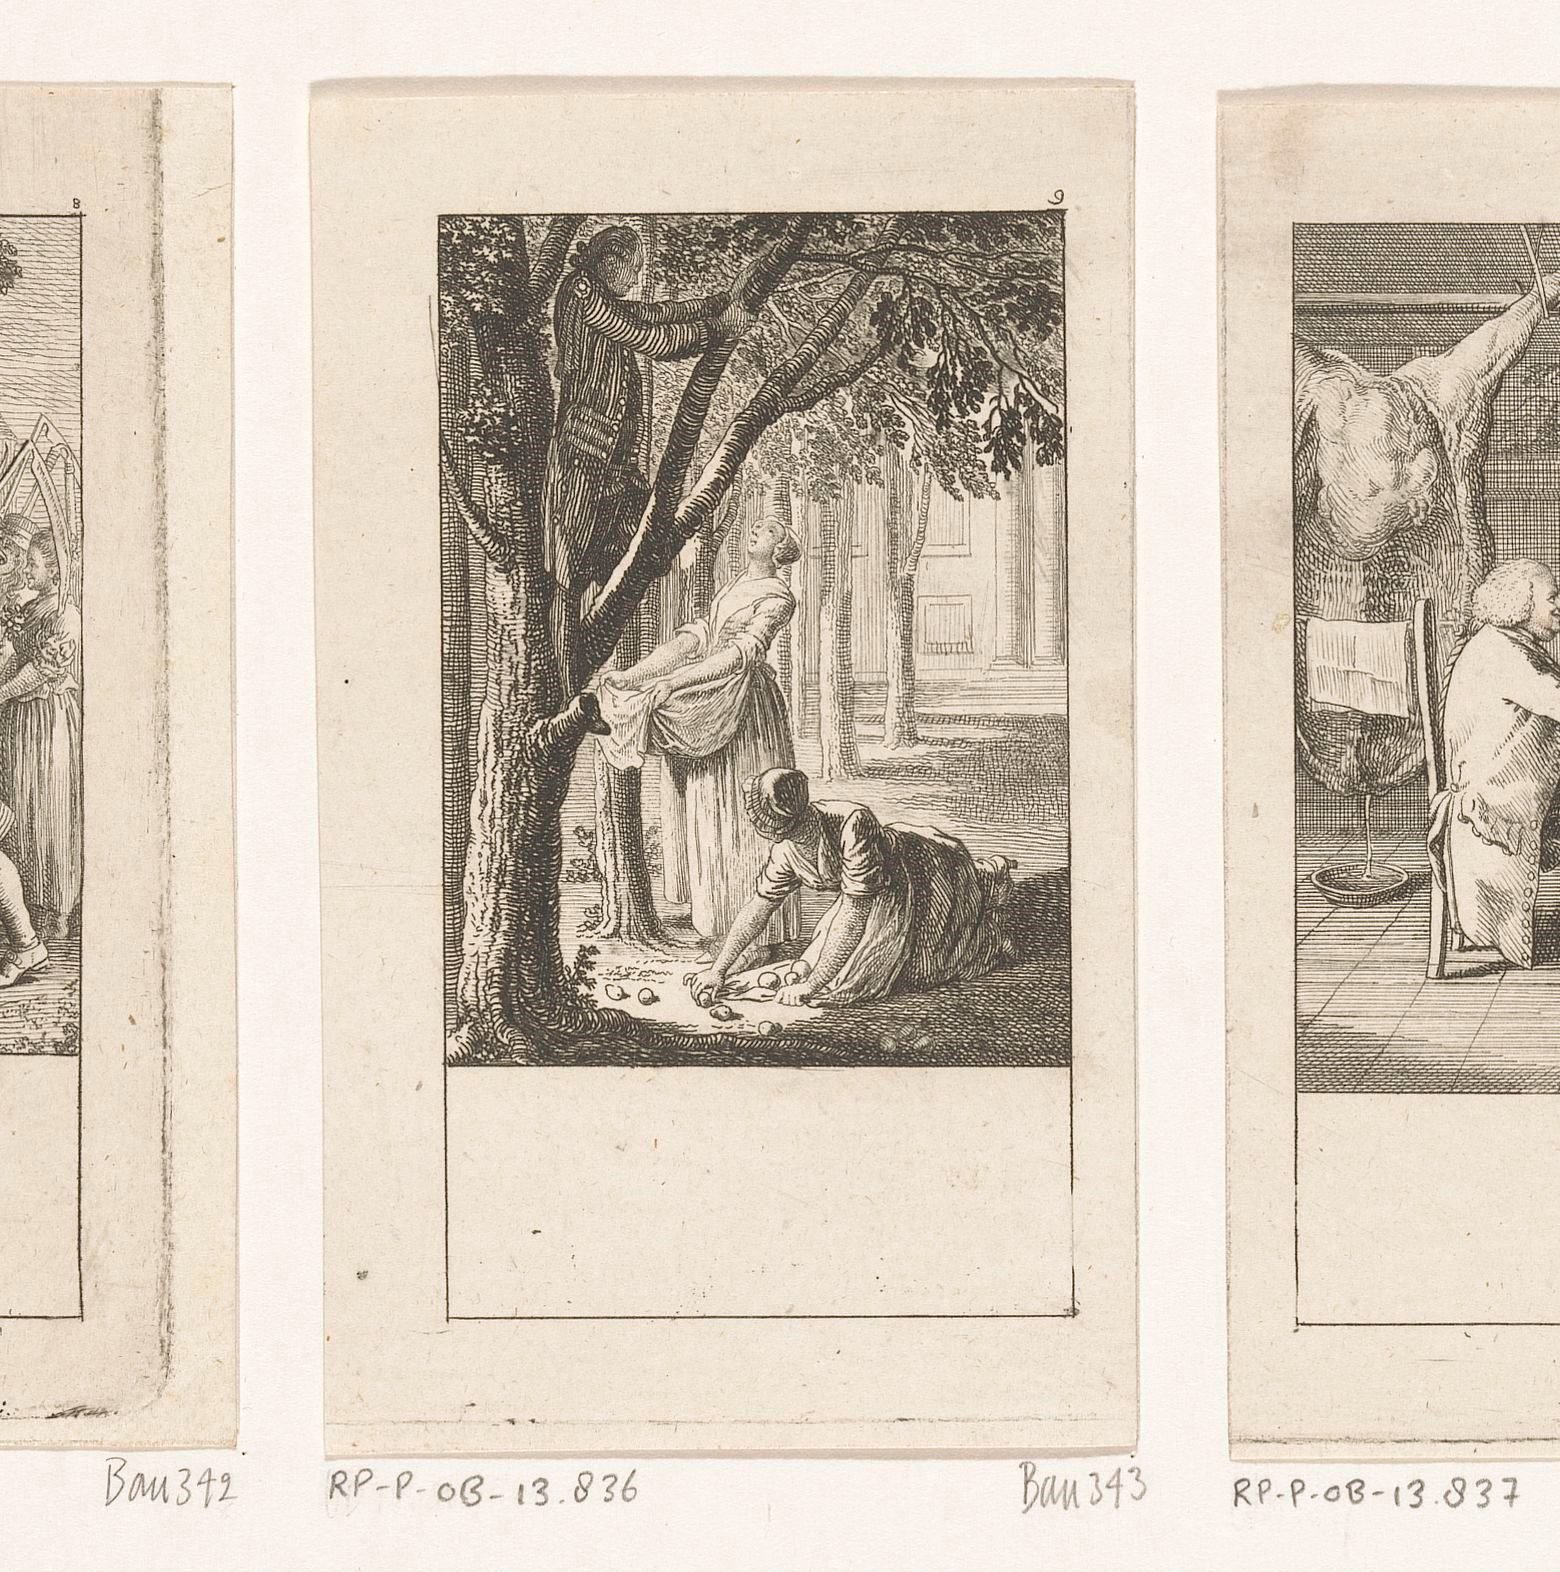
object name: print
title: September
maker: daniel nikolaus chodowiecki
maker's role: draughtsman, print maker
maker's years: 1726-1801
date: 1777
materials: paper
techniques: etching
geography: berlin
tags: shaking down, tossing down the fruit, september and its 'labours'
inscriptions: collector's mark: Lugt 2228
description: Afkomstig uit een serie met de twaalf maanden. Deze serie werd op een plaat geëtst. Een latere staat van deze serie werd gebruikt in: Königl. Großbrit. Churf. Braunschw. Lüneb. Genealogischen Kalender, auf das Jahr 1778. Lauenburg: Johann Georg Berenberg.